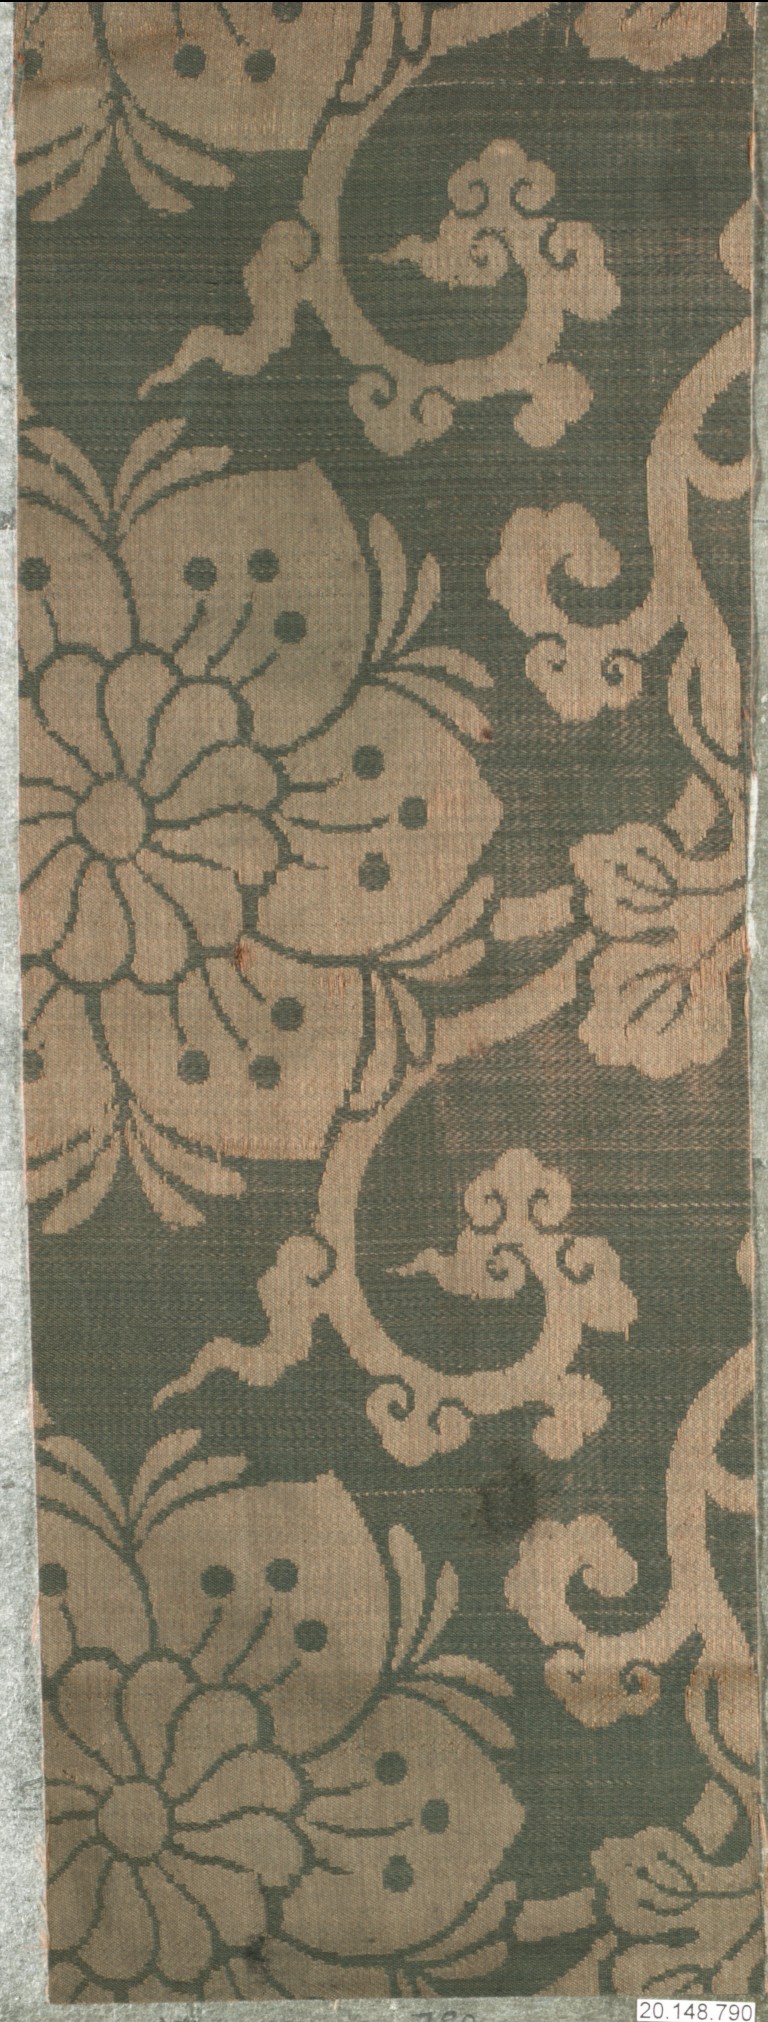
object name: piece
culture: japanese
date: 1701-1800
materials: silk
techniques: compound weave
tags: flowers,leaves